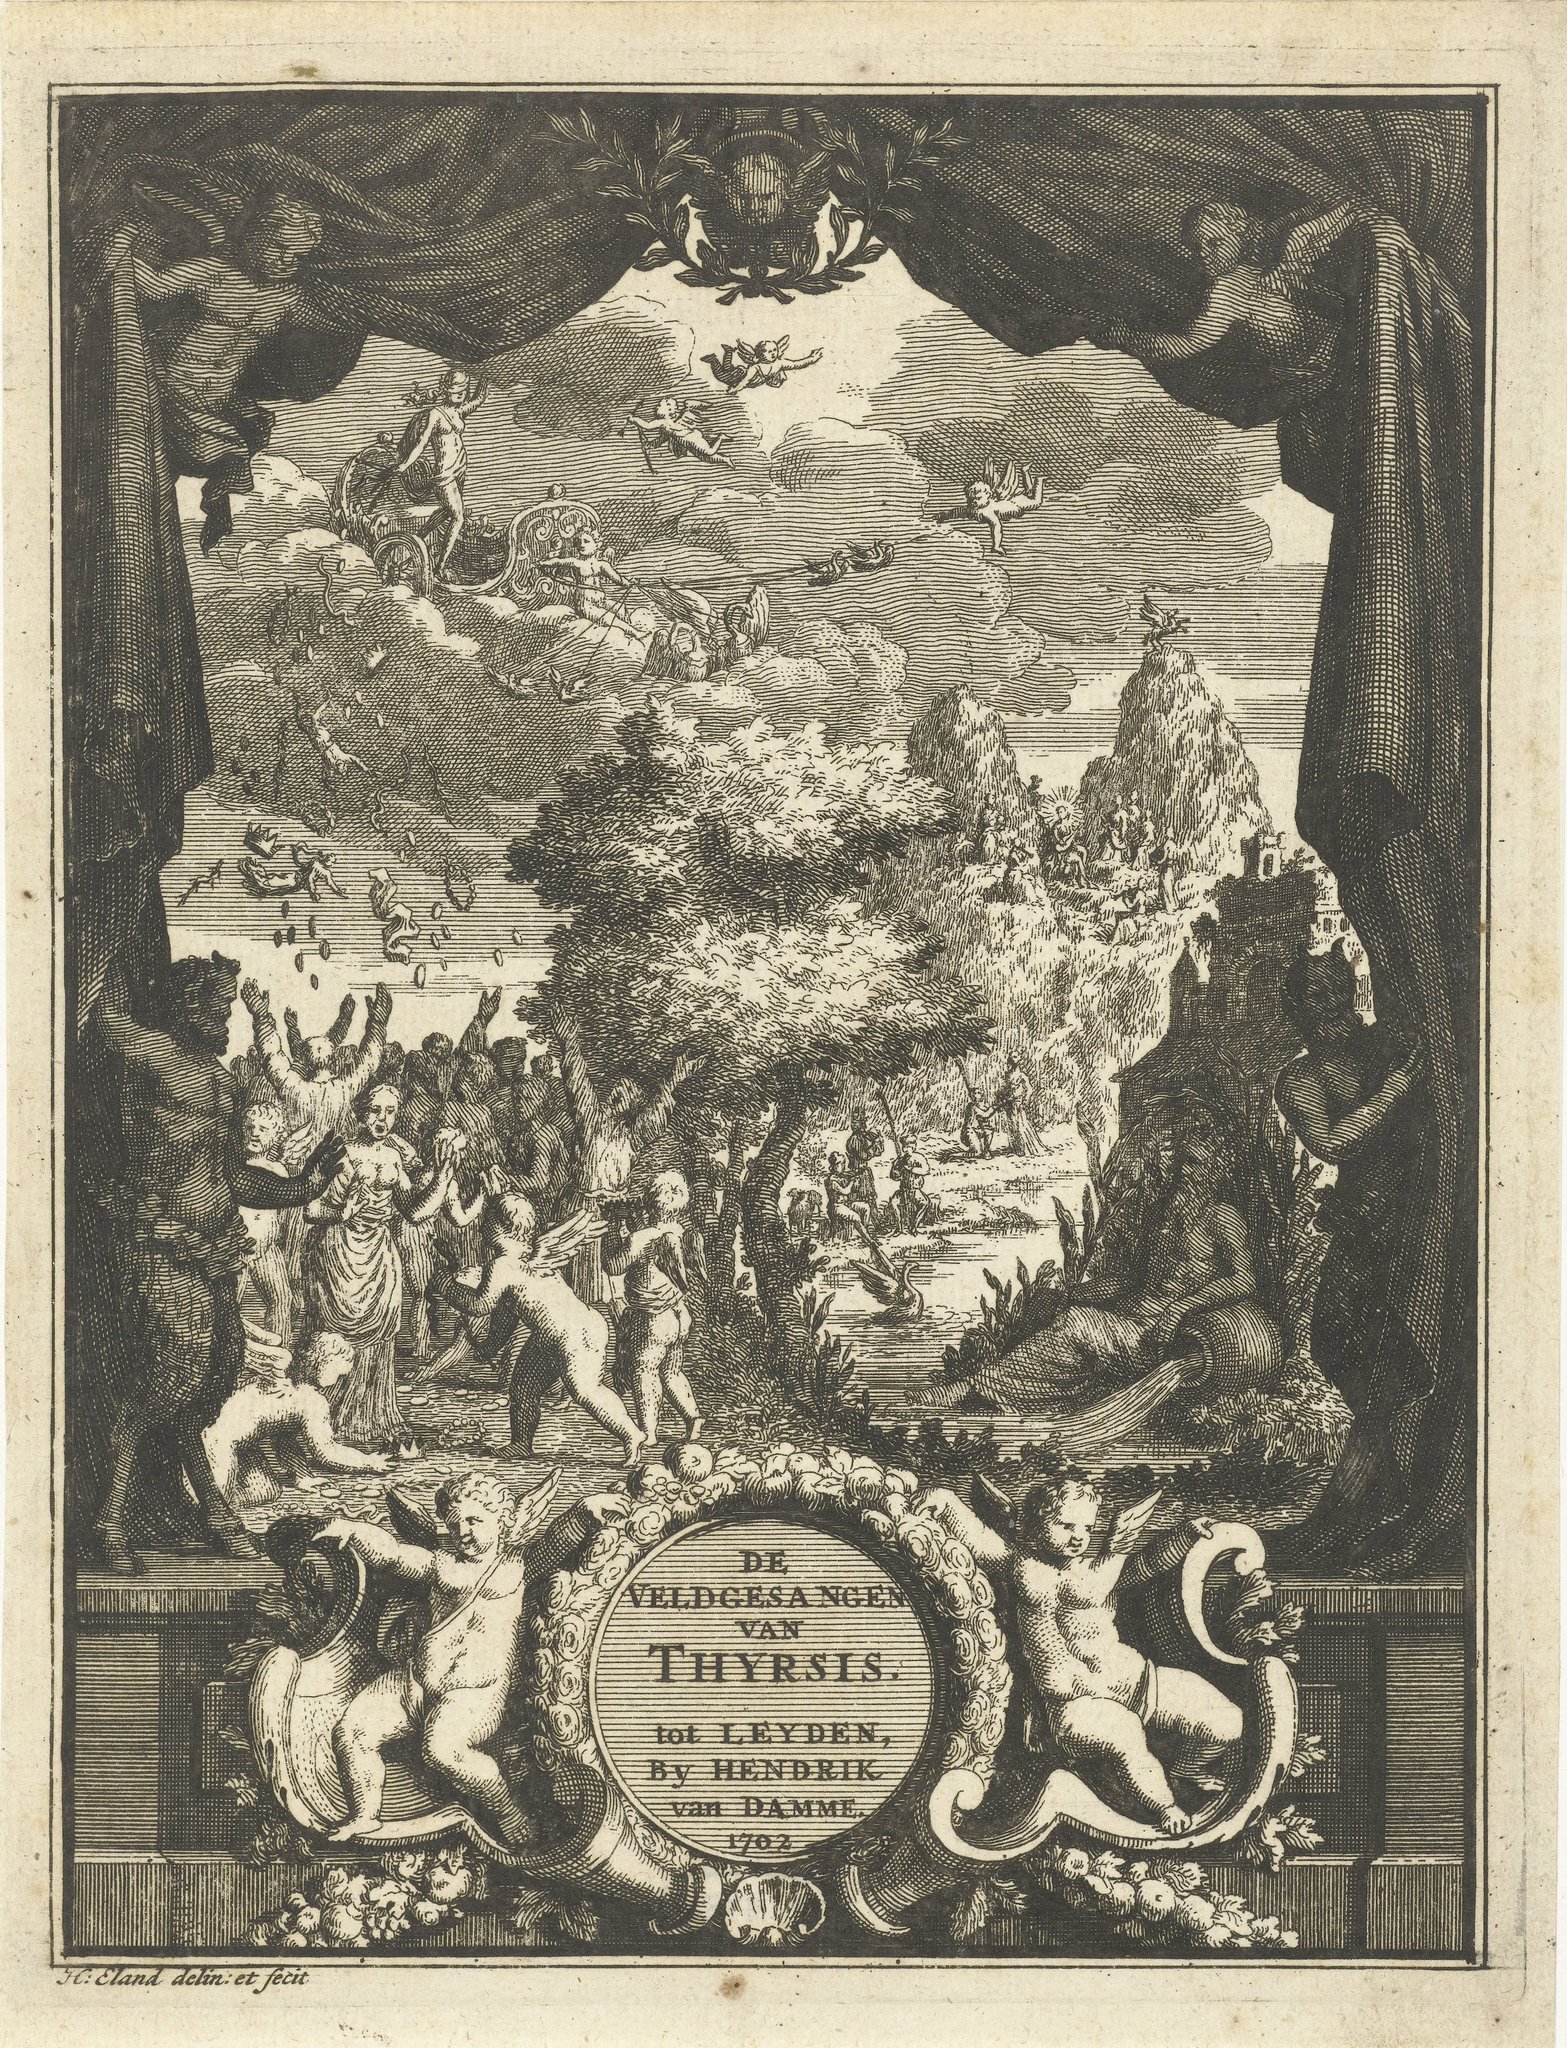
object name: print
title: De Veldgesangen van Thyrsis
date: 1702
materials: paper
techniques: etching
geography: amsterdam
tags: satyr(s) (in general)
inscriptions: collector's mark: Lugt 2228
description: Twee saters en putti houden een toneelgordijn open waarachter een landschap met bergen en een rivier te zien is. Vanuit de lucht gooit de geblinddoekte Fortuna symbolen voor rijkdom en verval naar de mensenmassa beneden. Voor het toneel een rond cartouche met de titel en aan weerszijden een putto.